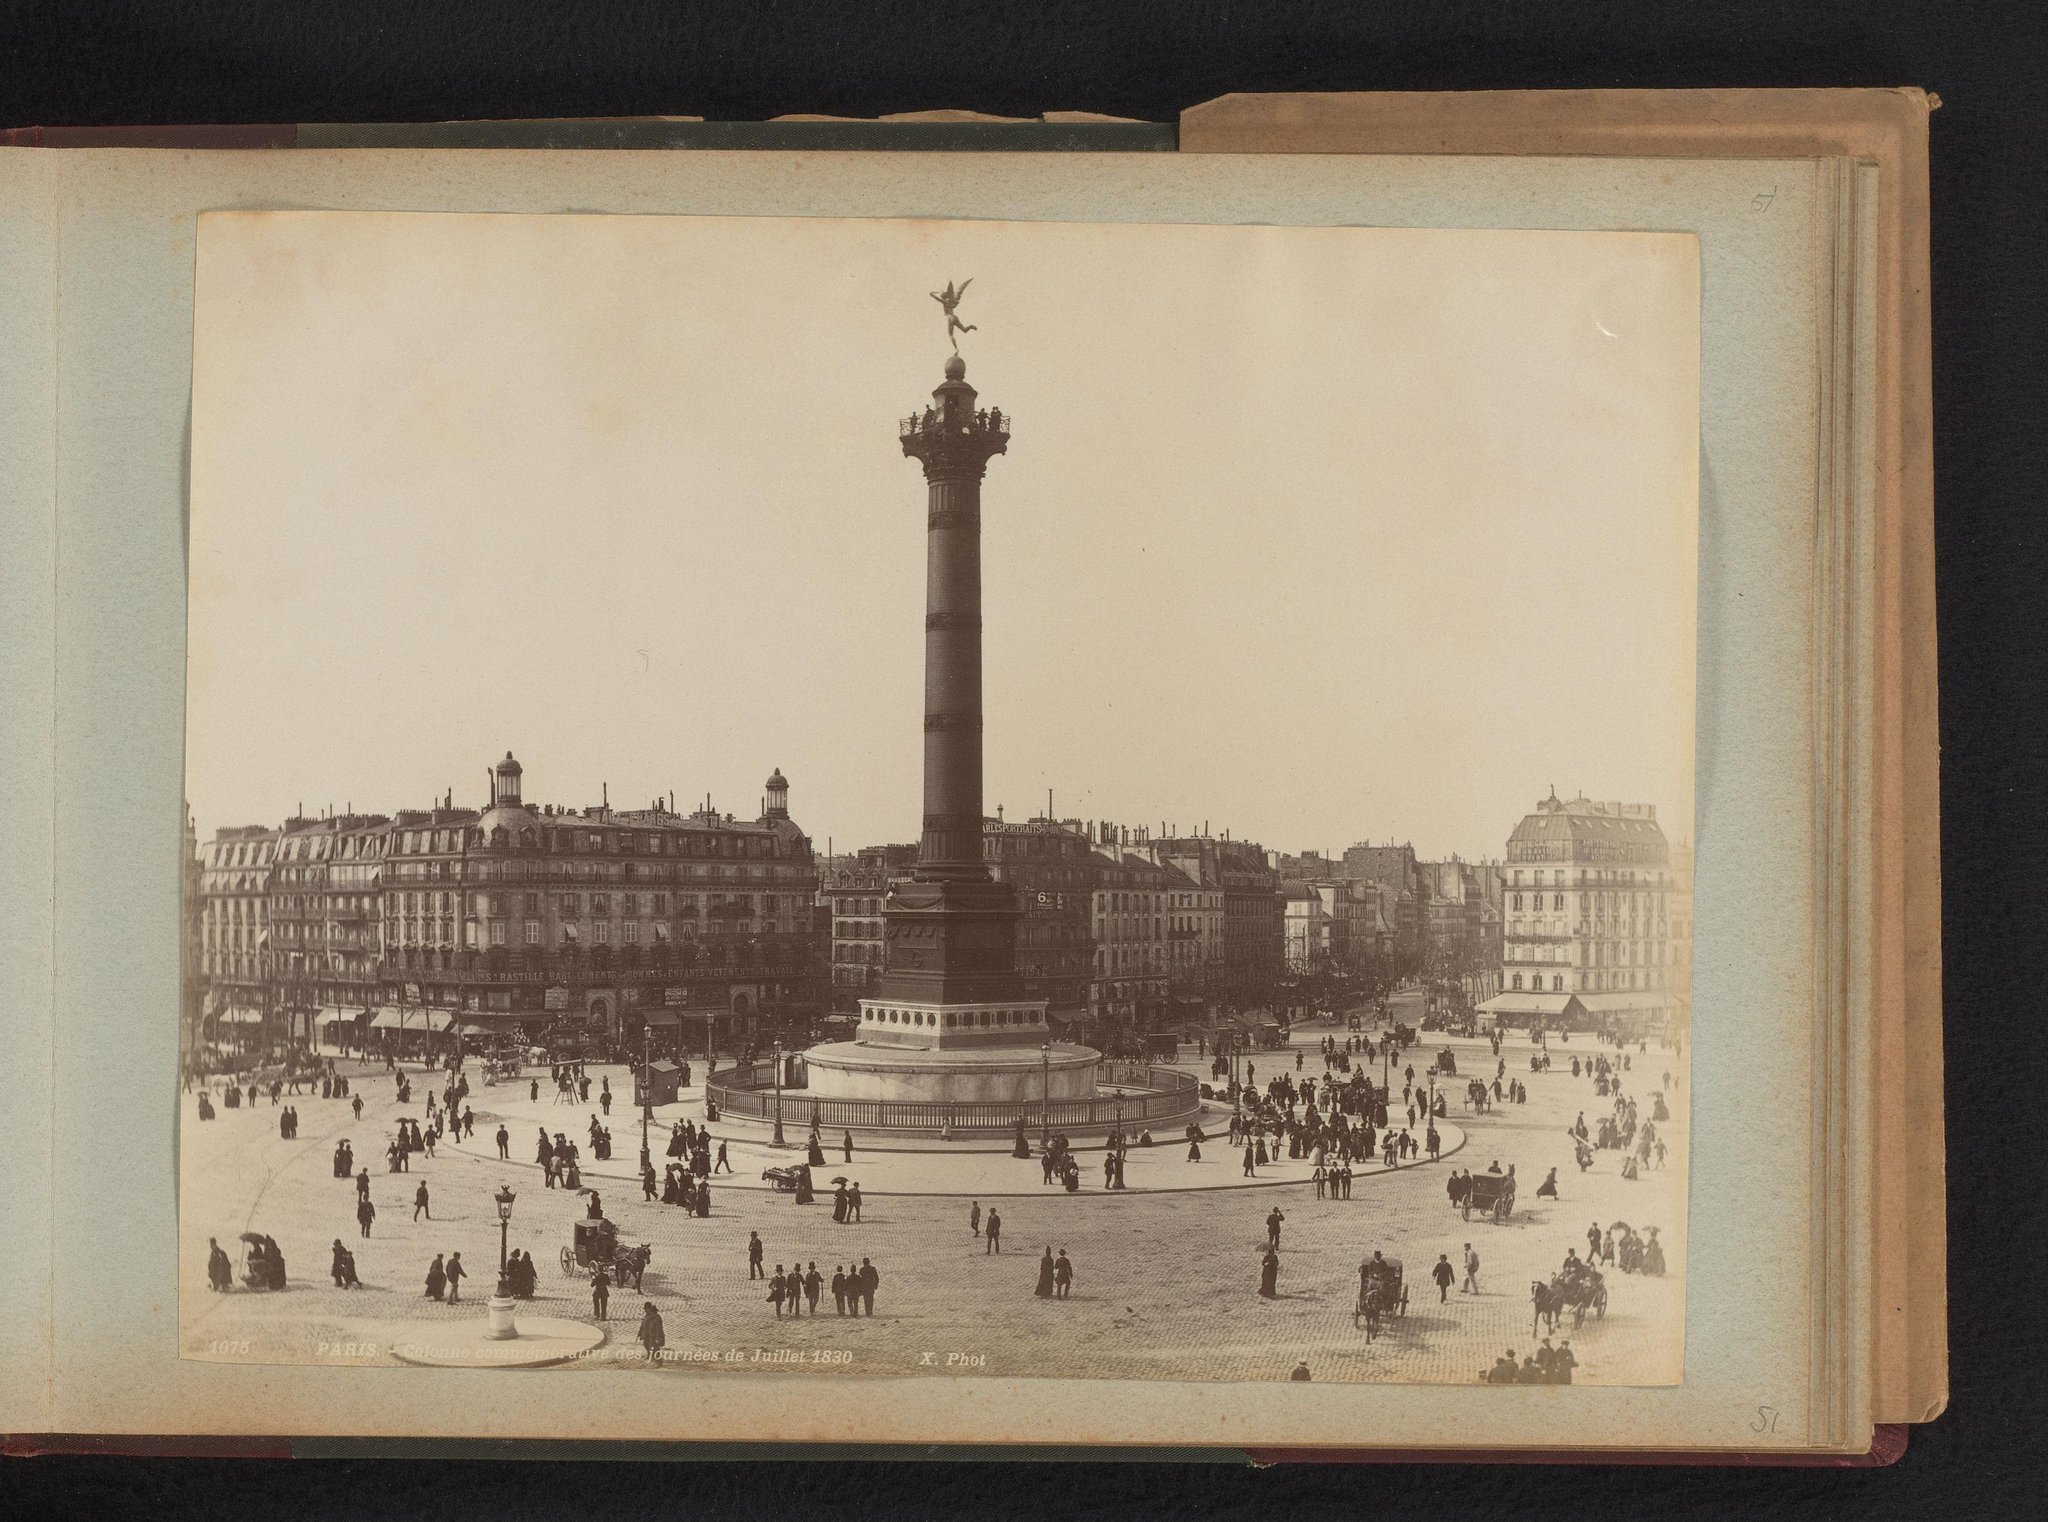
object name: photograph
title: Colonne commémorative des journées de Juillet 1830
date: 1887-1900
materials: paper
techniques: albumen print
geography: paris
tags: square, place, circus, etc., obelisk, needle, telescope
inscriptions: number: ‘51’, number: ‘1075’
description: Deze foto maakt deel uit van album. Links naast de Colonne de Juillet is een straattelescoop te zien.